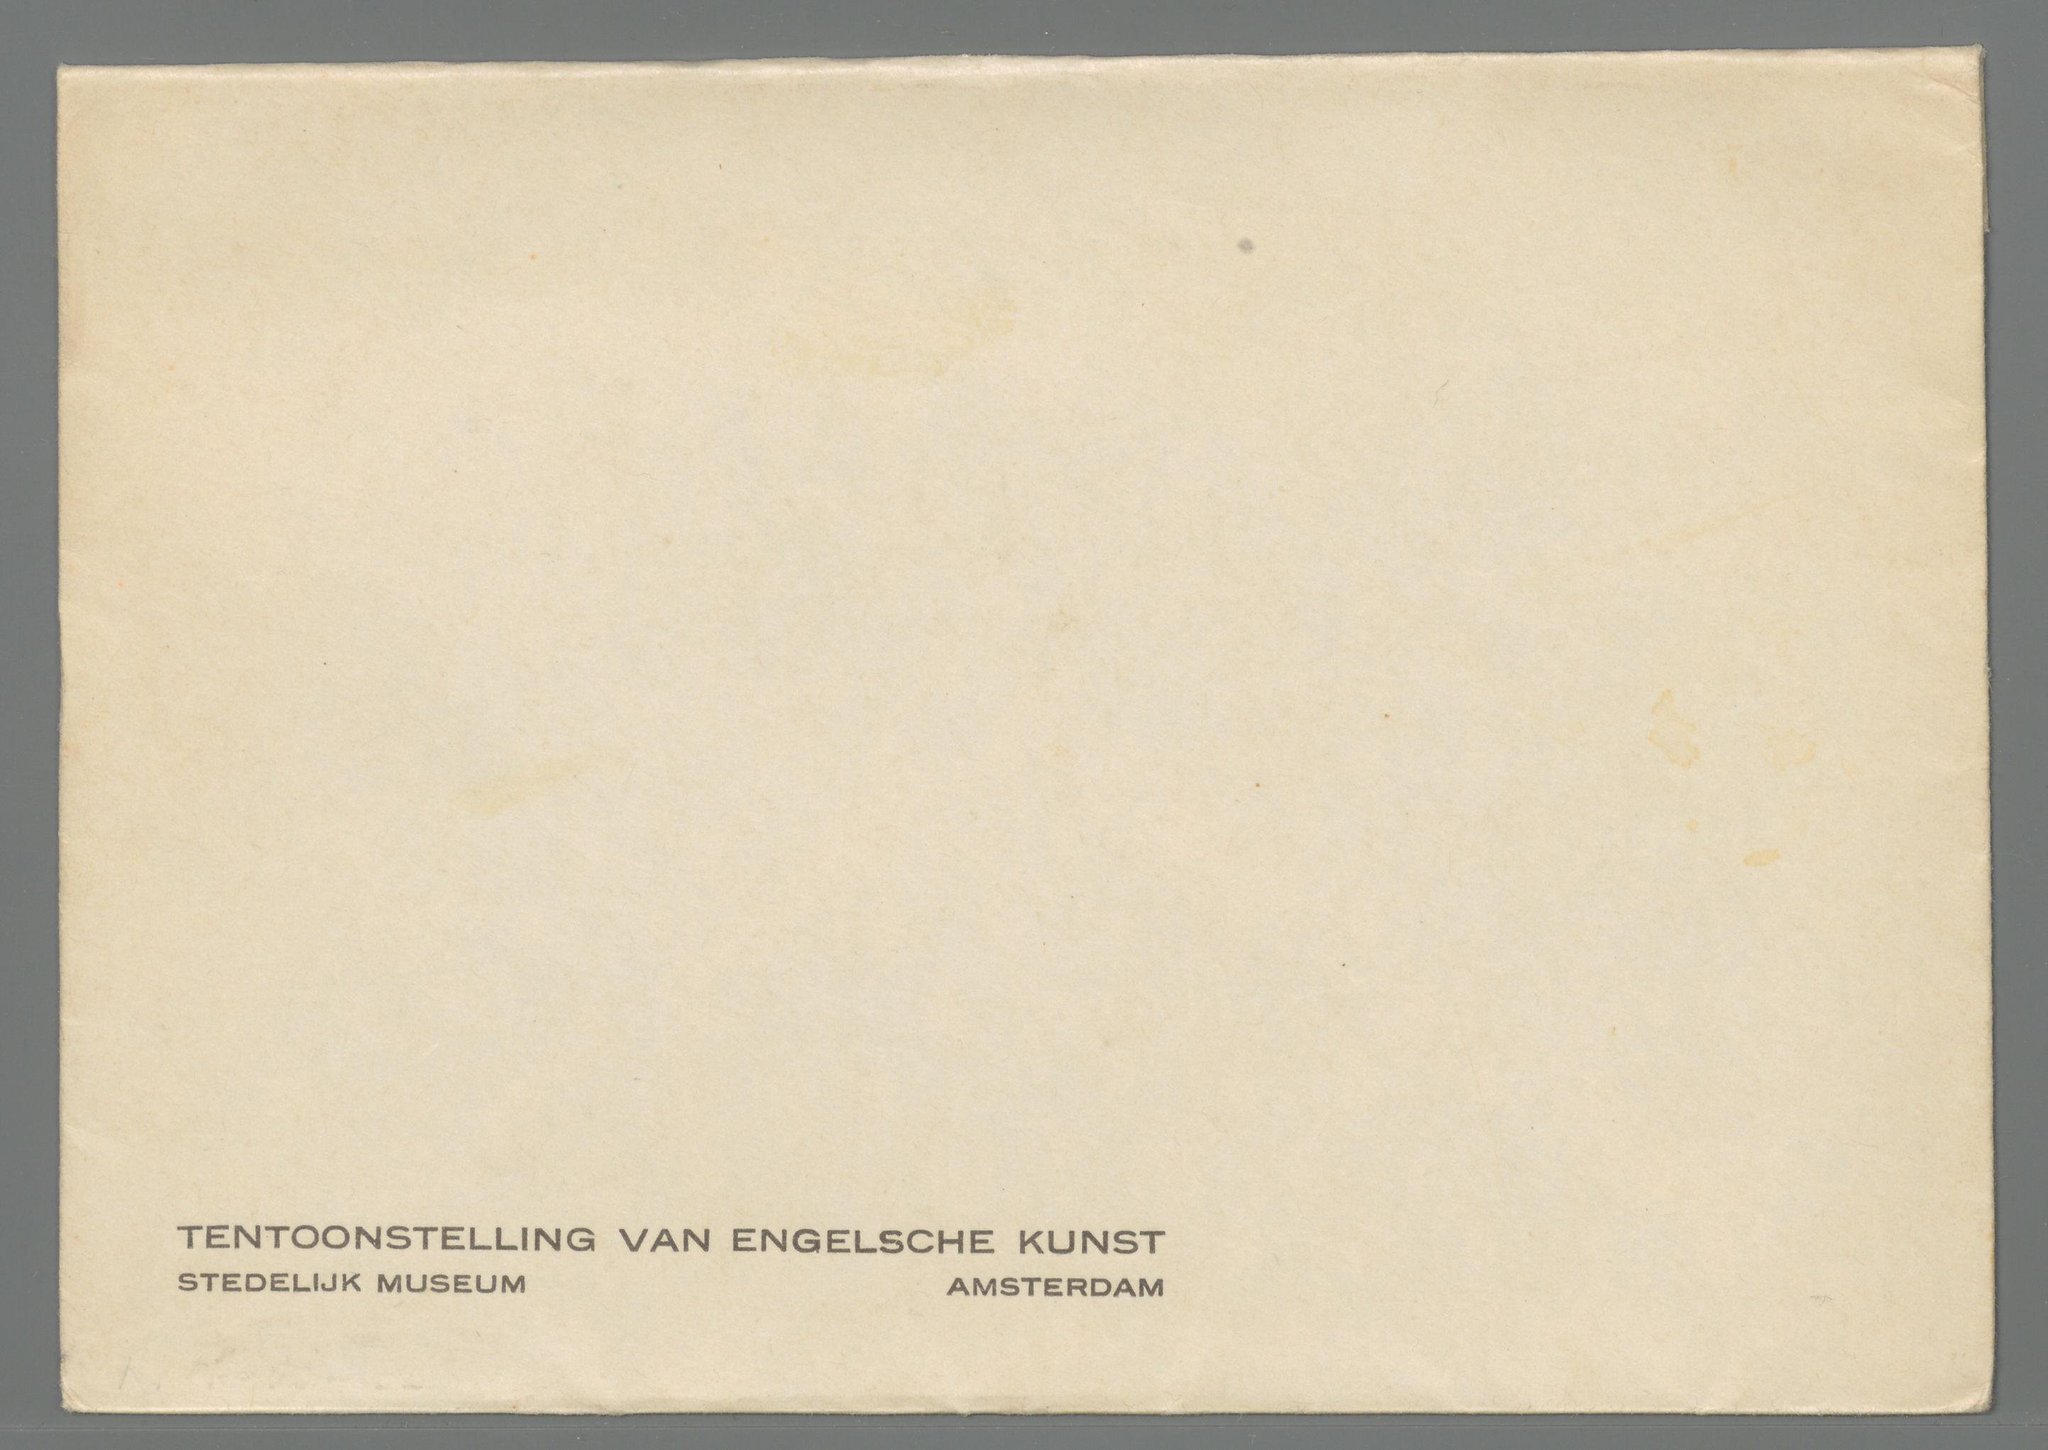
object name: wrapper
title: Tentoonstelling van Engelsche Kunst. Stedelijk Museum. Amsterdam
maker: Anonymous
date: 1936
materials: paper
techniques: letterpress printing